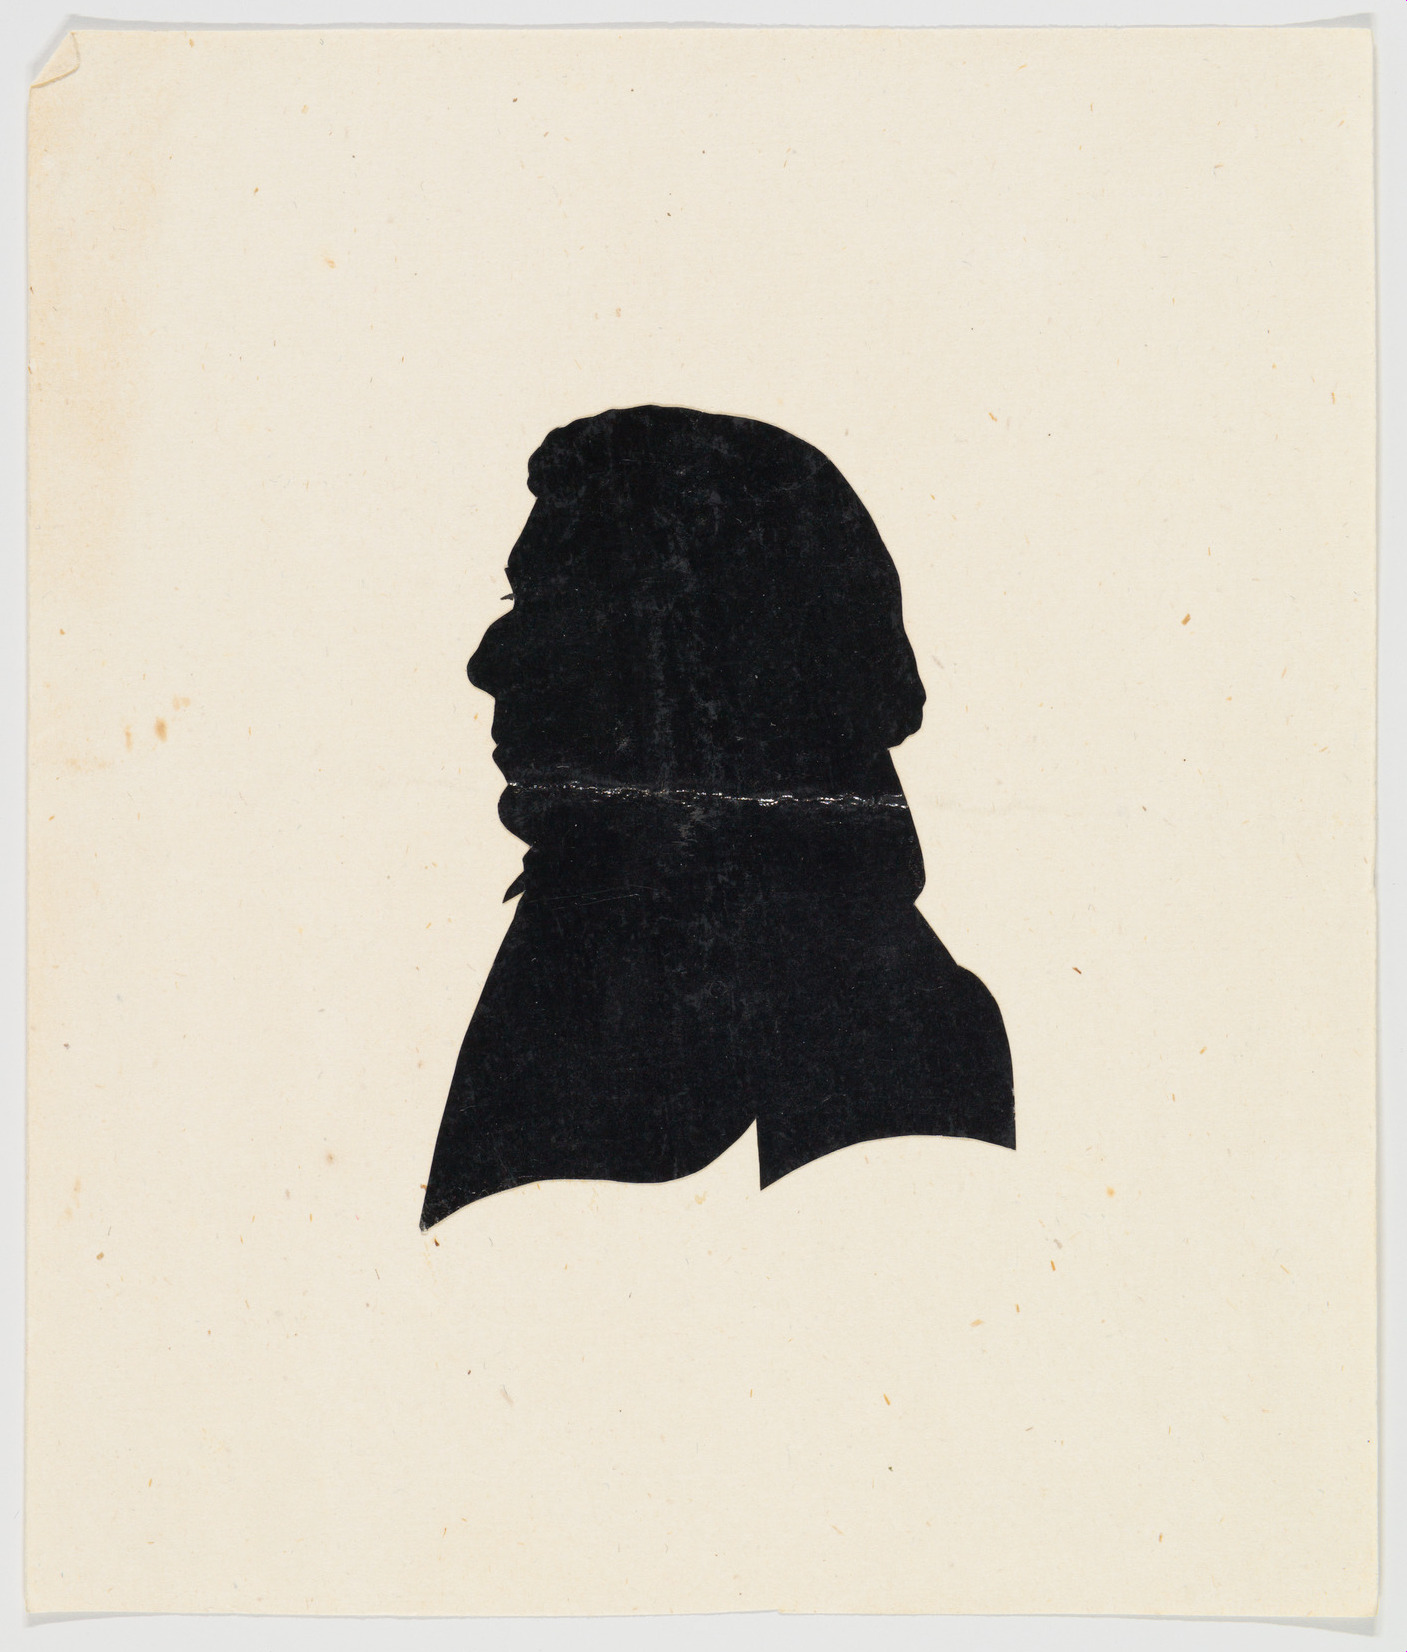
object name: cut paper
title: Unidentified profile portrait, older man facing left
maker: anonymous, german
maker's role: artist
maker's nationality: german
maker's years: 1400-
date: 1773-1820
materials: paper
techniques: cutting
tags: men,profiles